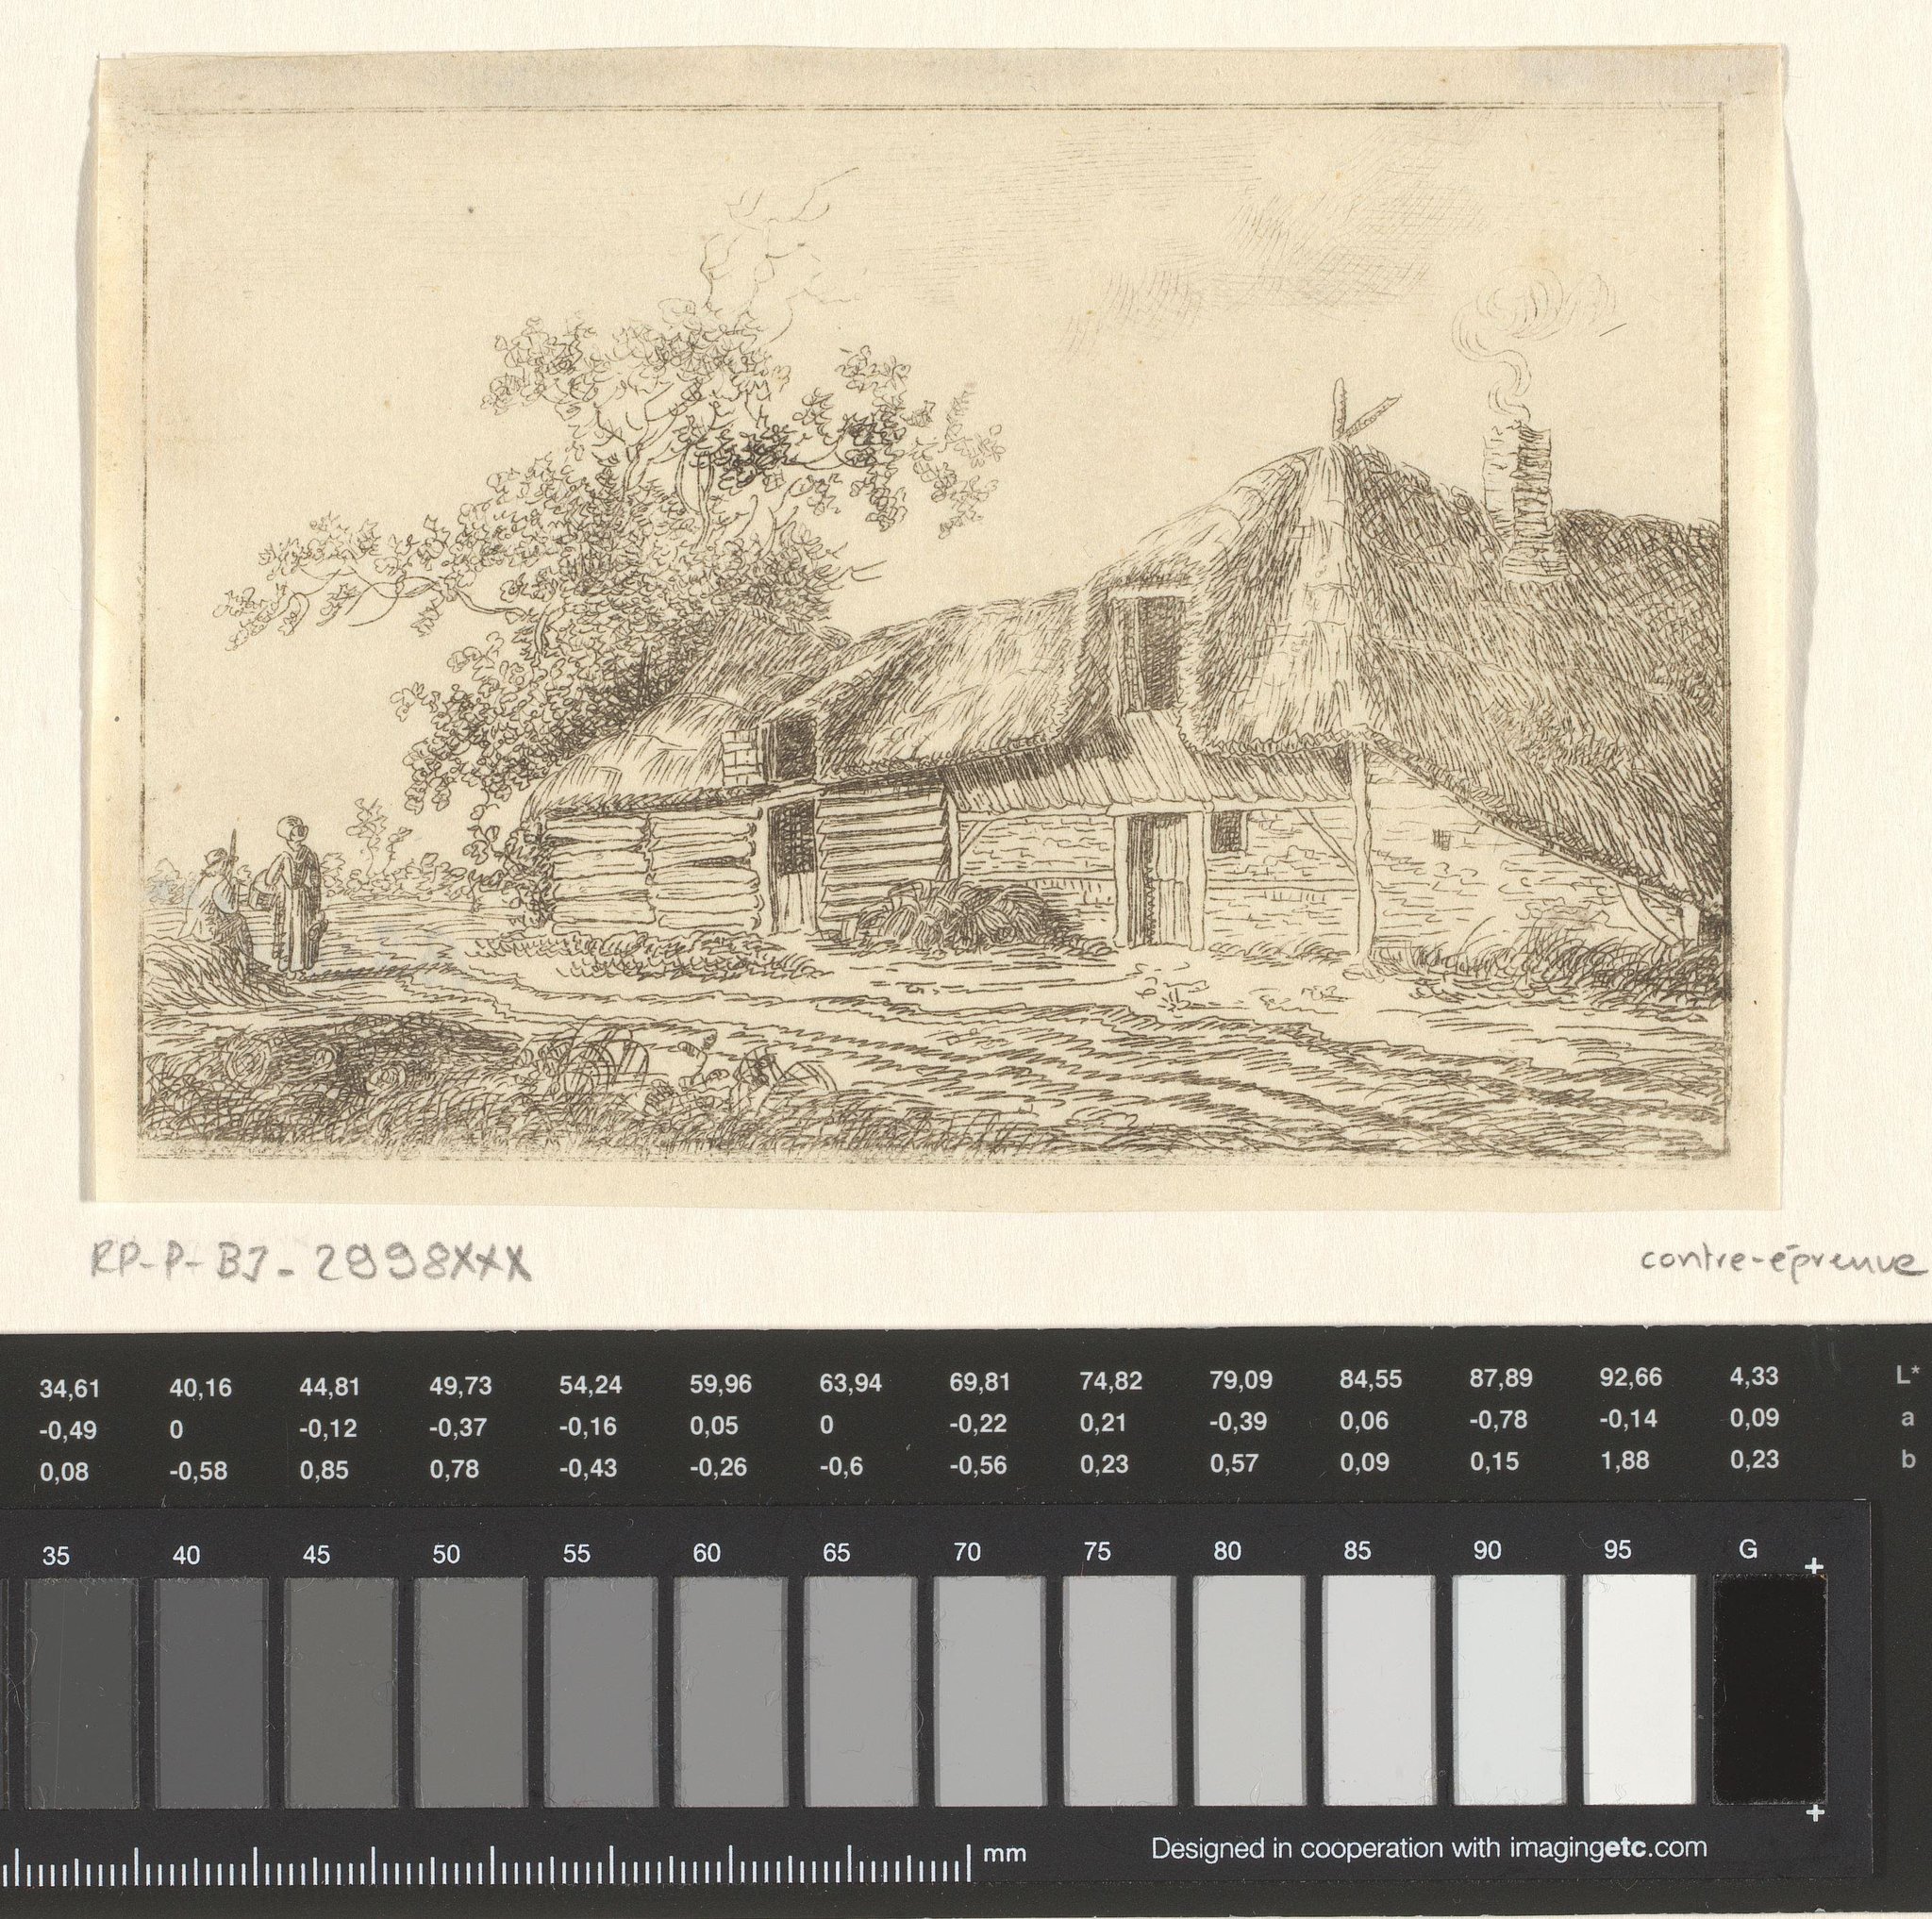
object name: print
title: Twee figuren voor een boerderij bij Zwolle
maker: anthonie van den bos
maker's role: draughtsman, print maker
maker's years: 1763-1838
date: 1778-1838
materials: paper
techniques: printmaking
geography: netherlands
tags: farm or solitary house in landscape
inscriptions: collector's mark: Lugt 2228